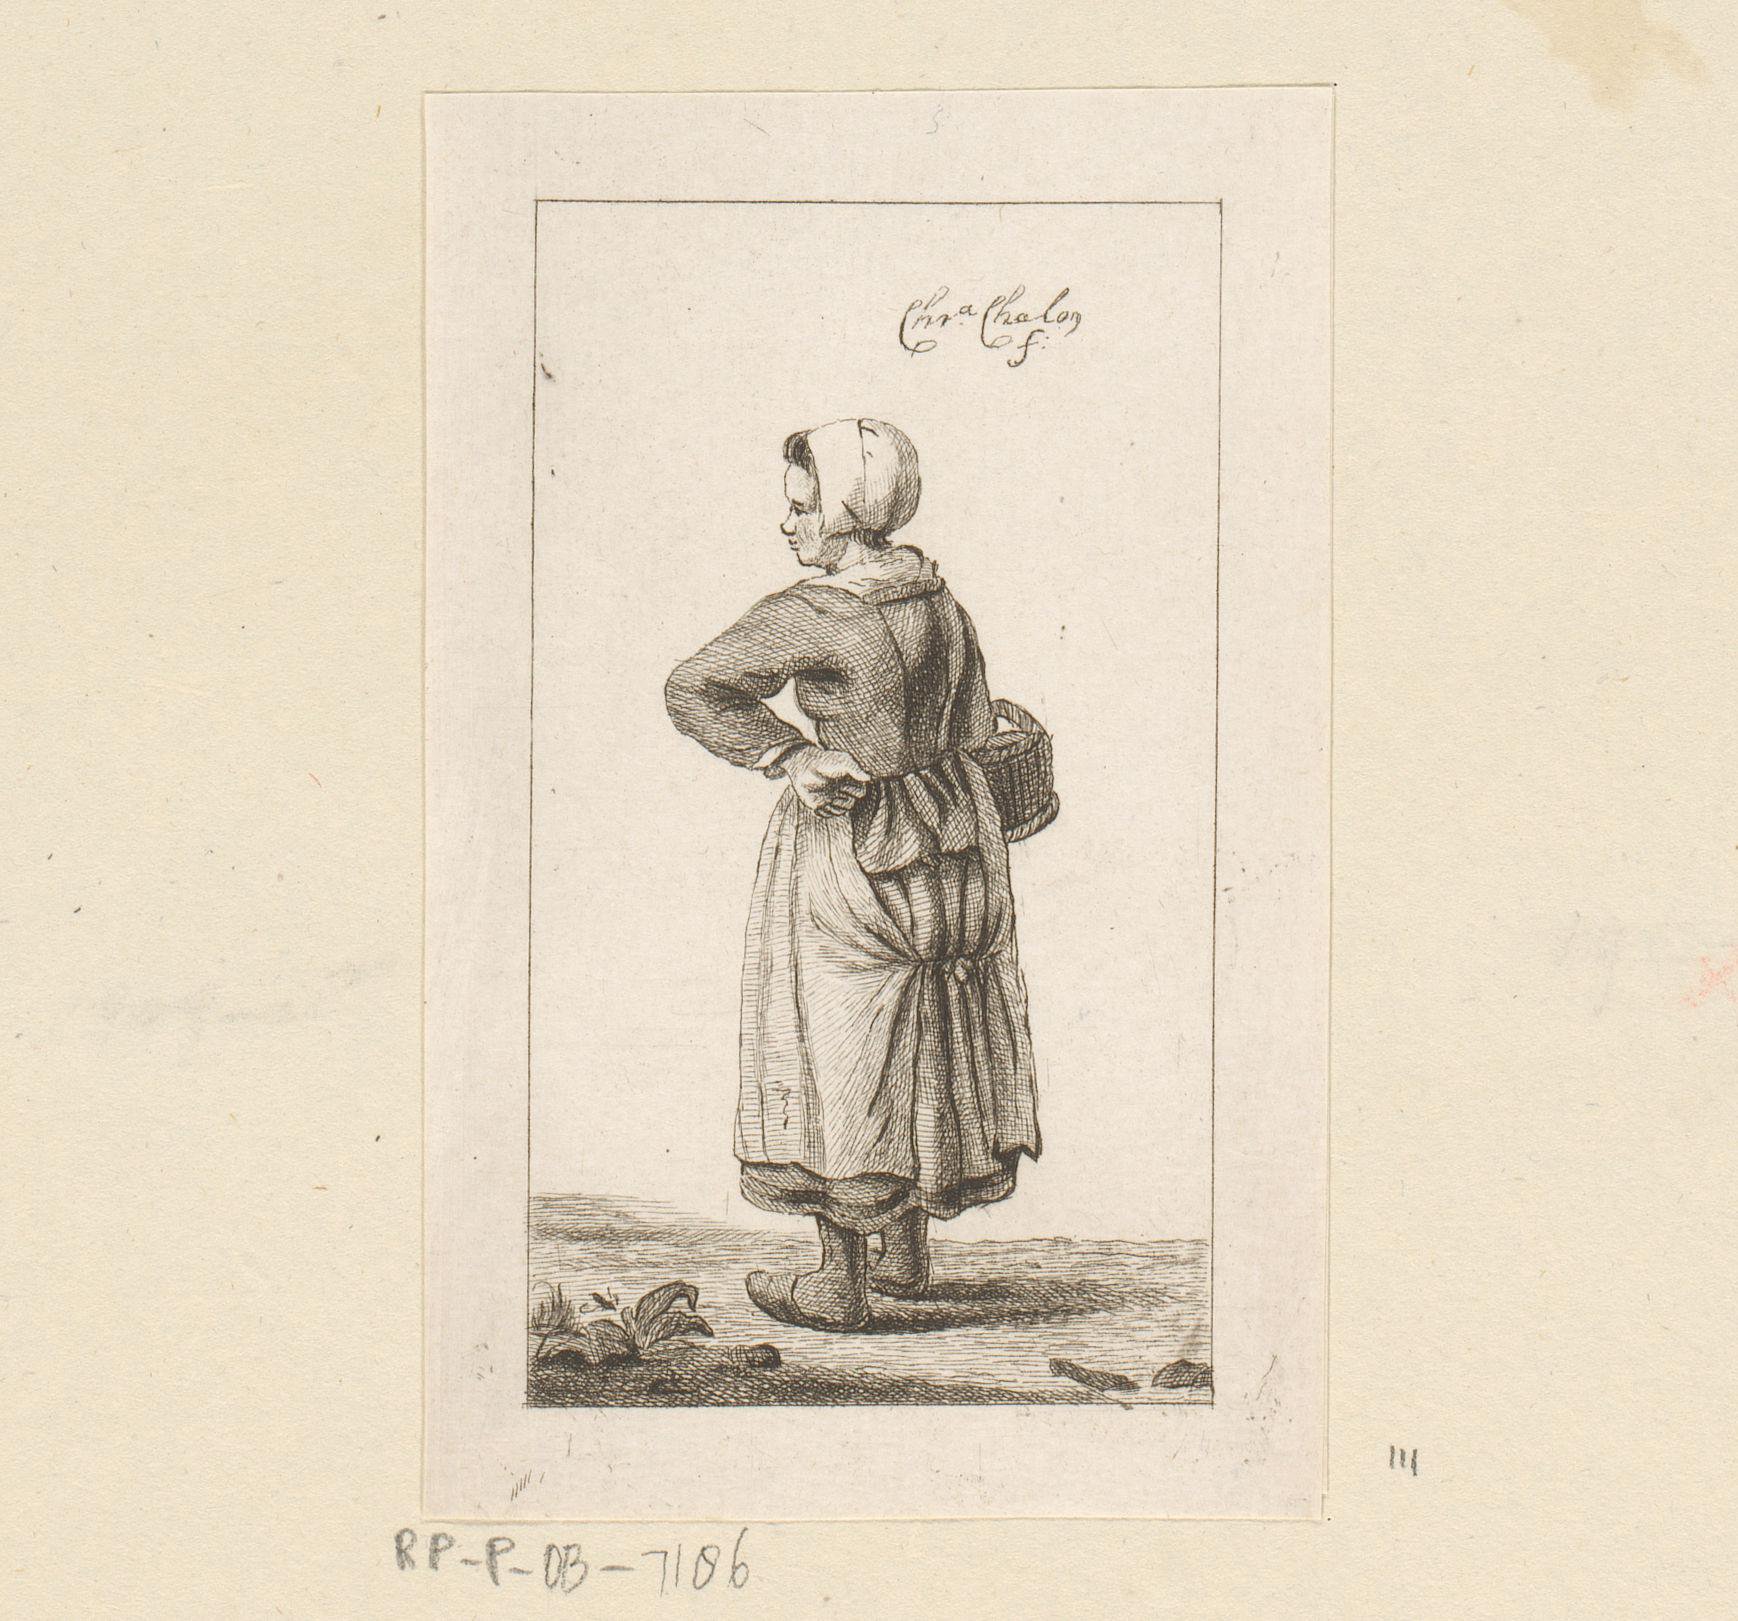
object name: print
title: Vrouw met mand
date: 1779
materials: paper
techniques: etching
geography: leiden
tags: carrying something in basket, bag, rucksack, etc., the (nude) human figure; 'corpo humano' (ripa) (+ young female (human being))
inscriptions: collector's mark: Lugt 2228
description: Een jonge vrouw met een mandje aan haar rechterarm en een hand in haar zij, schuin van achteren gezien.